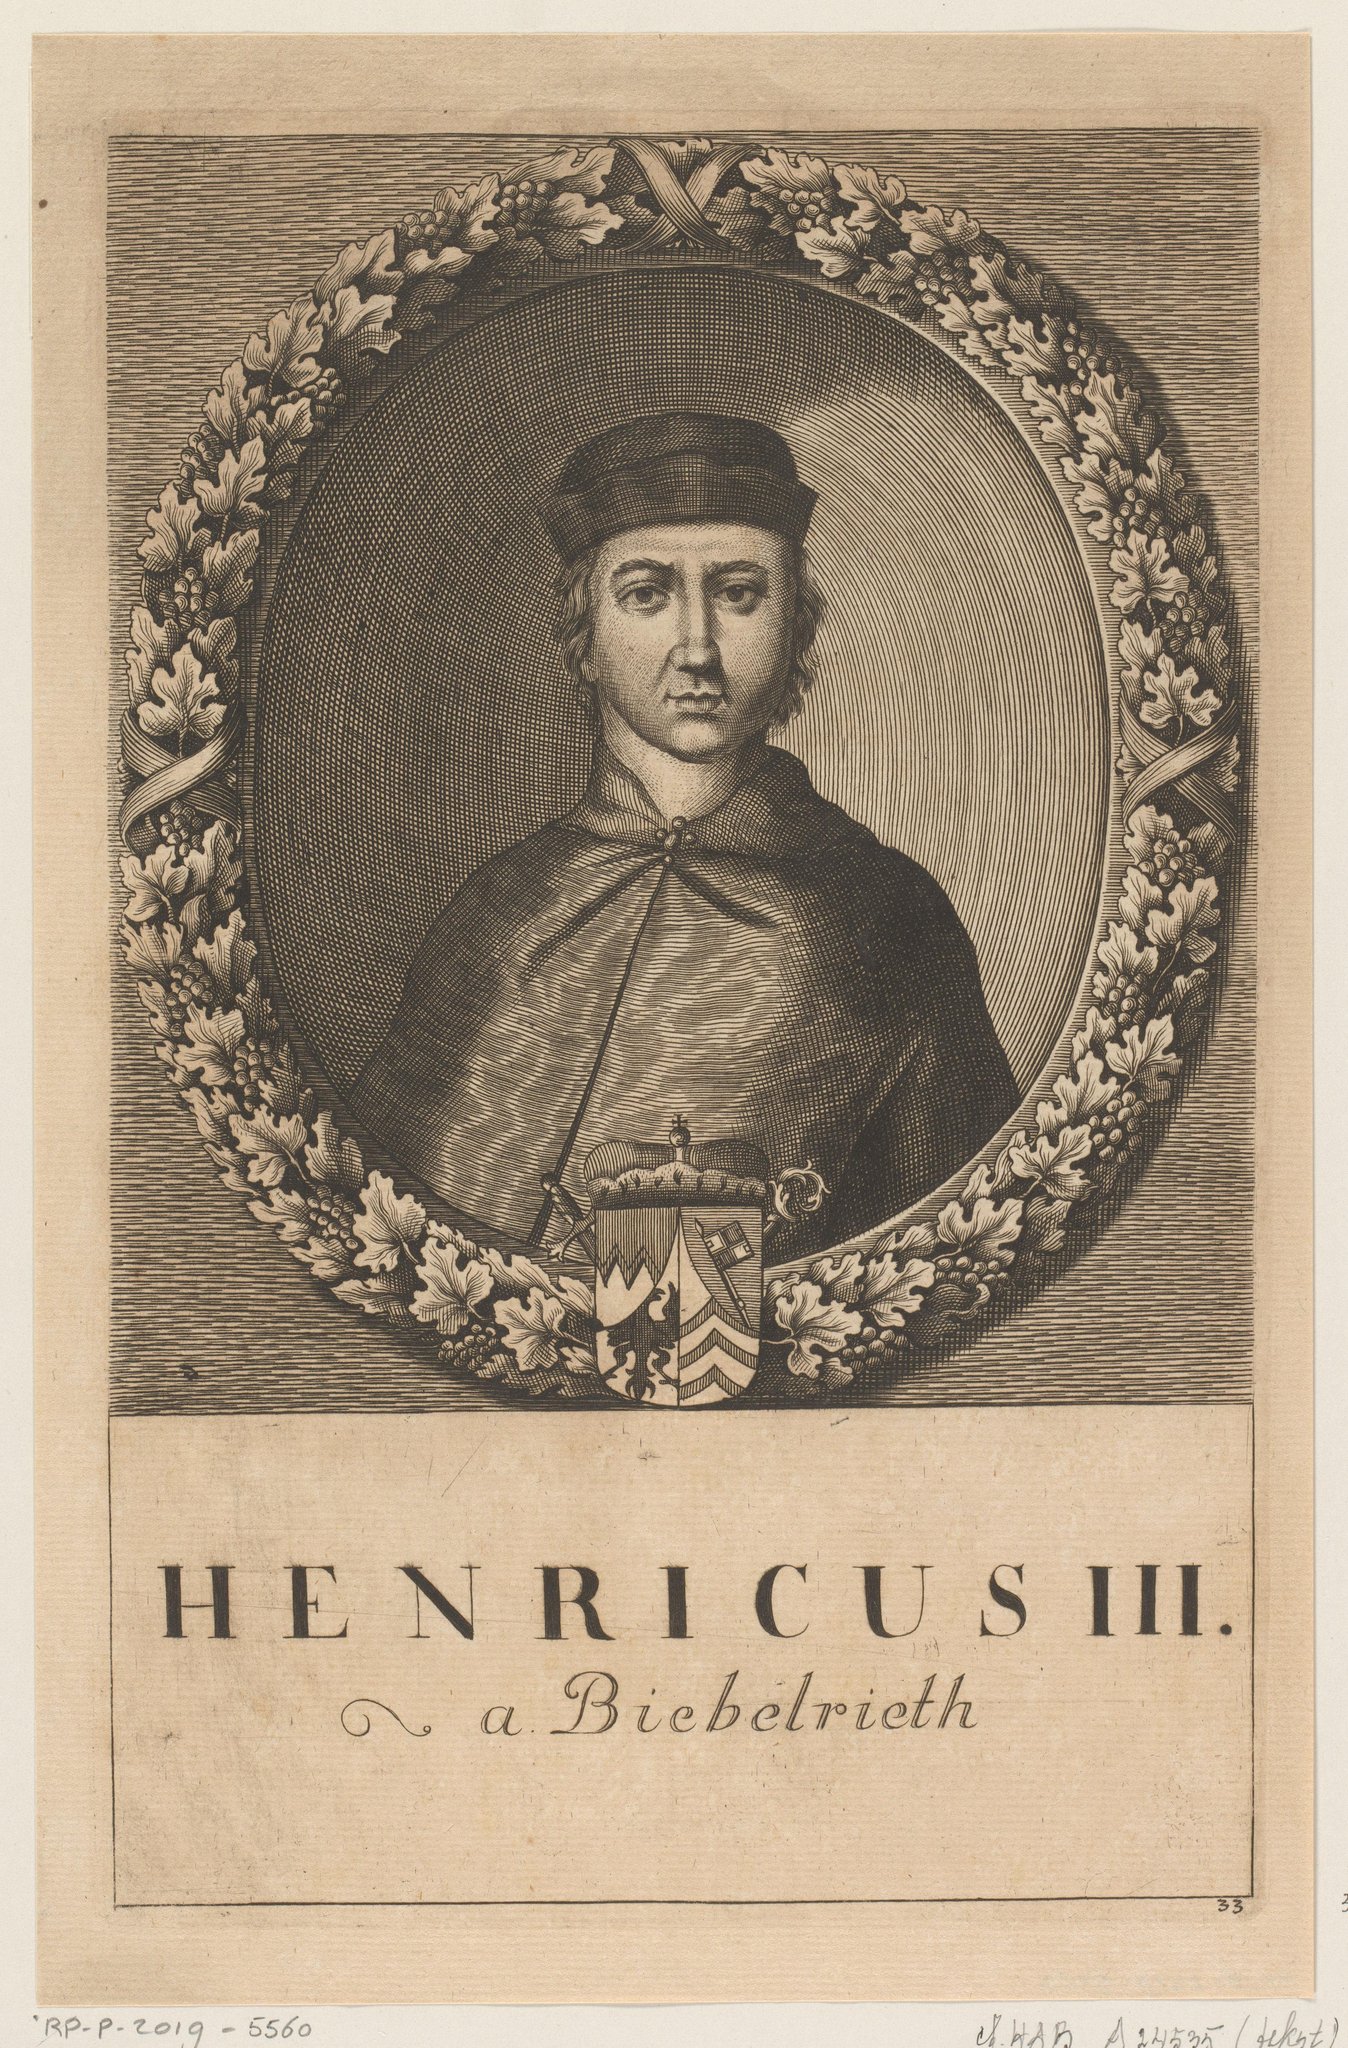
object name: print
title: Henricus III. a Biebelrieth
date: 1713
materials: paper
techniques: engraving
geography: frankfurt am main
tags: archbishop, bishop, etc. (roman catholic), historical persons, armorial bearing, heraldry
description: Prent uit: Ludewig, Johann Peter von. Geschicht-Schreiber von dem Bischoffthum Wirtzburg (...). Frankfurt am Main: Thomas Fritsch, 1713.